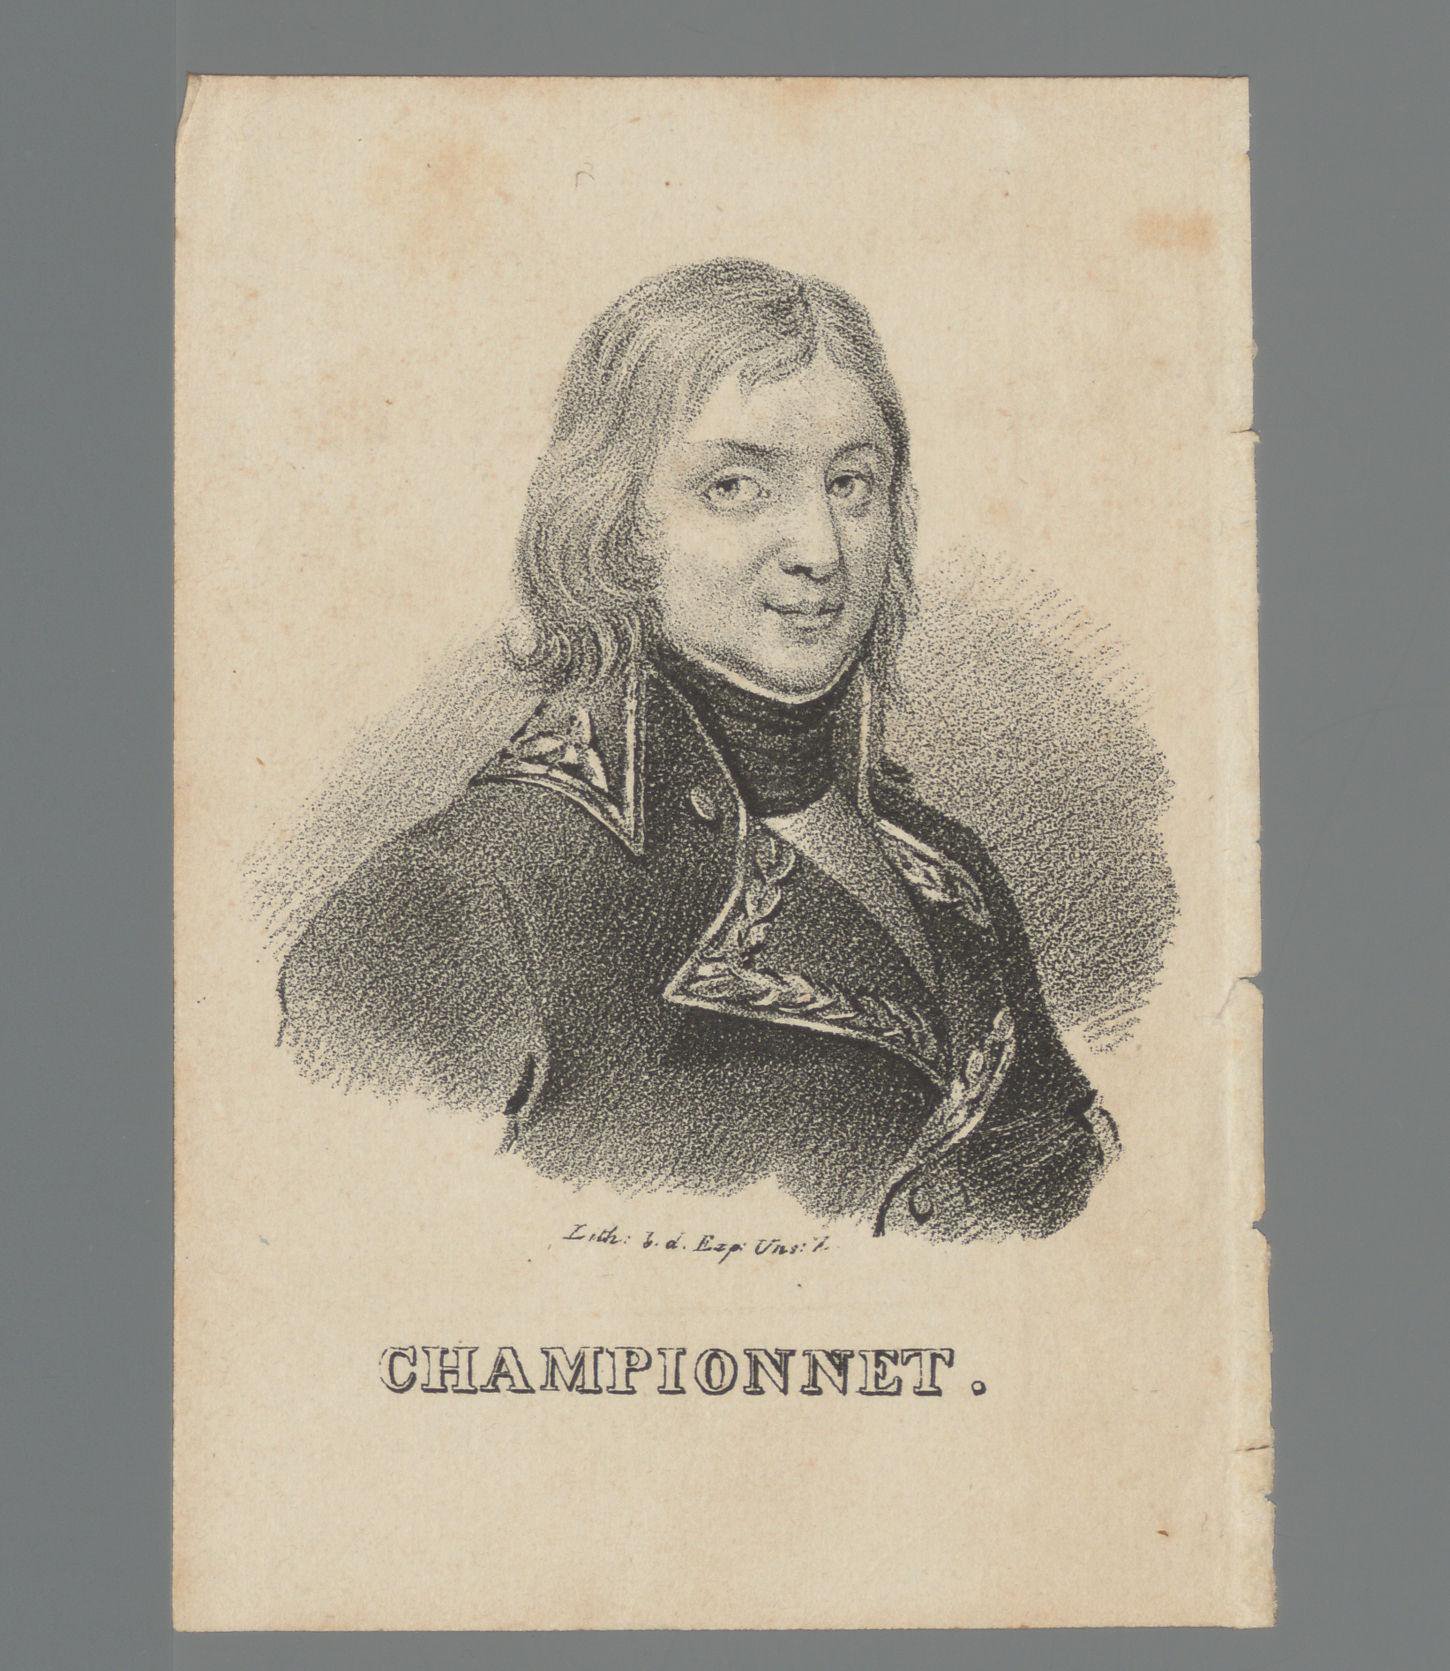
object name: print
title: Portret van Jean Étienne Championnet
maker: gottfried küstner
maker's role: print maker, printer, publisher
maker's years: 1800-1864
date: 1810-1864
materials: paper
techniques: lithograph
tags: ranks in the army, historical persons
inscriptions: collector's mark: Lugt 2228